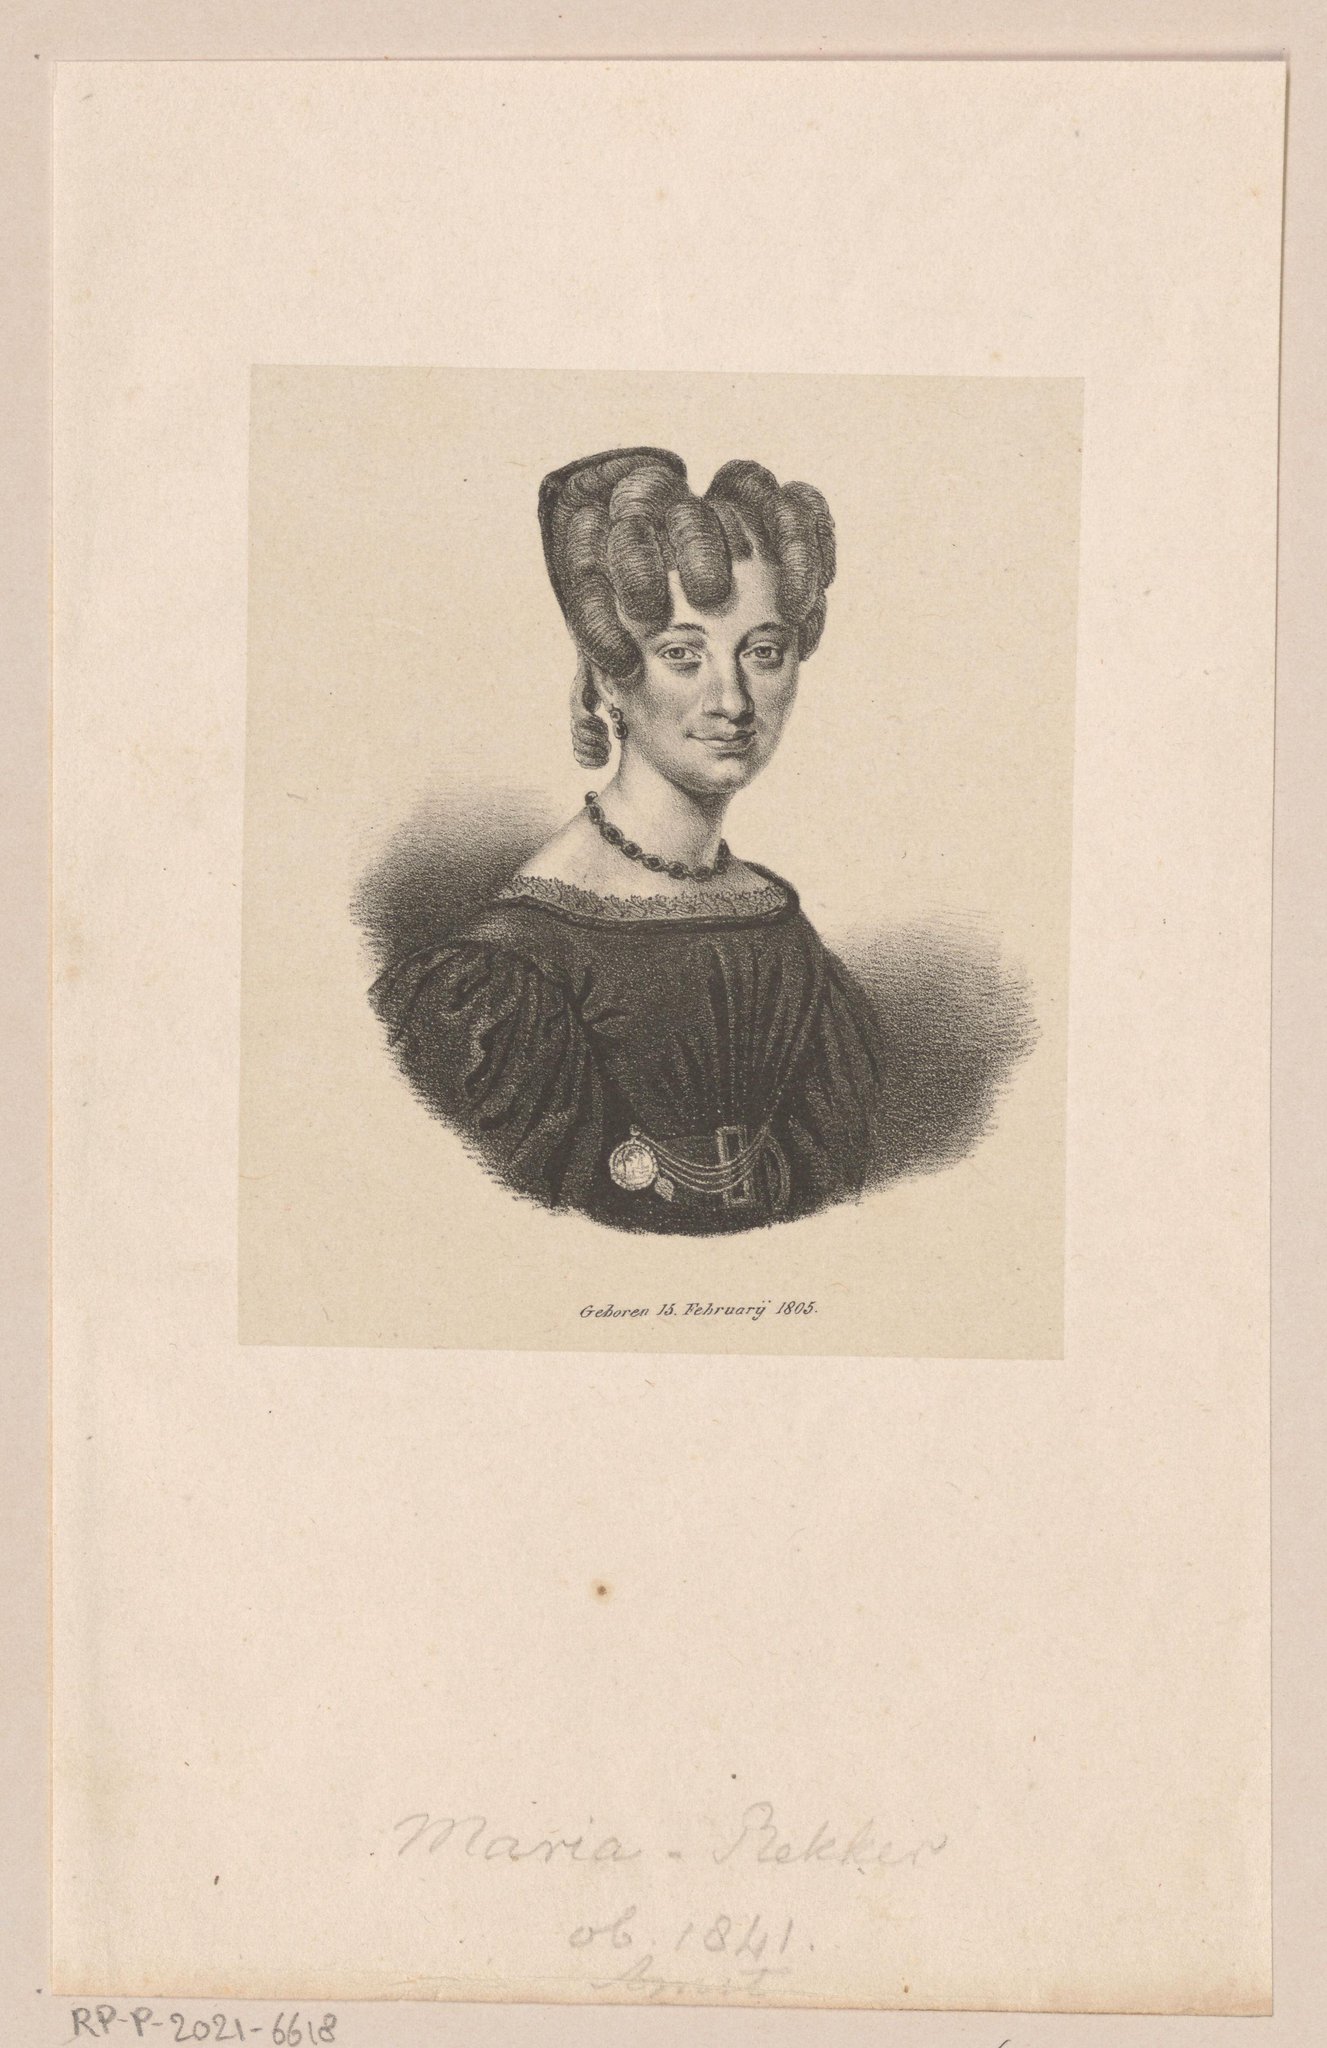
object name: print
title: Portret van Maria Rekker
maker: Anonymous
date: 1820-1851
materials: paper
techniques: lithograph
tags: historical persons